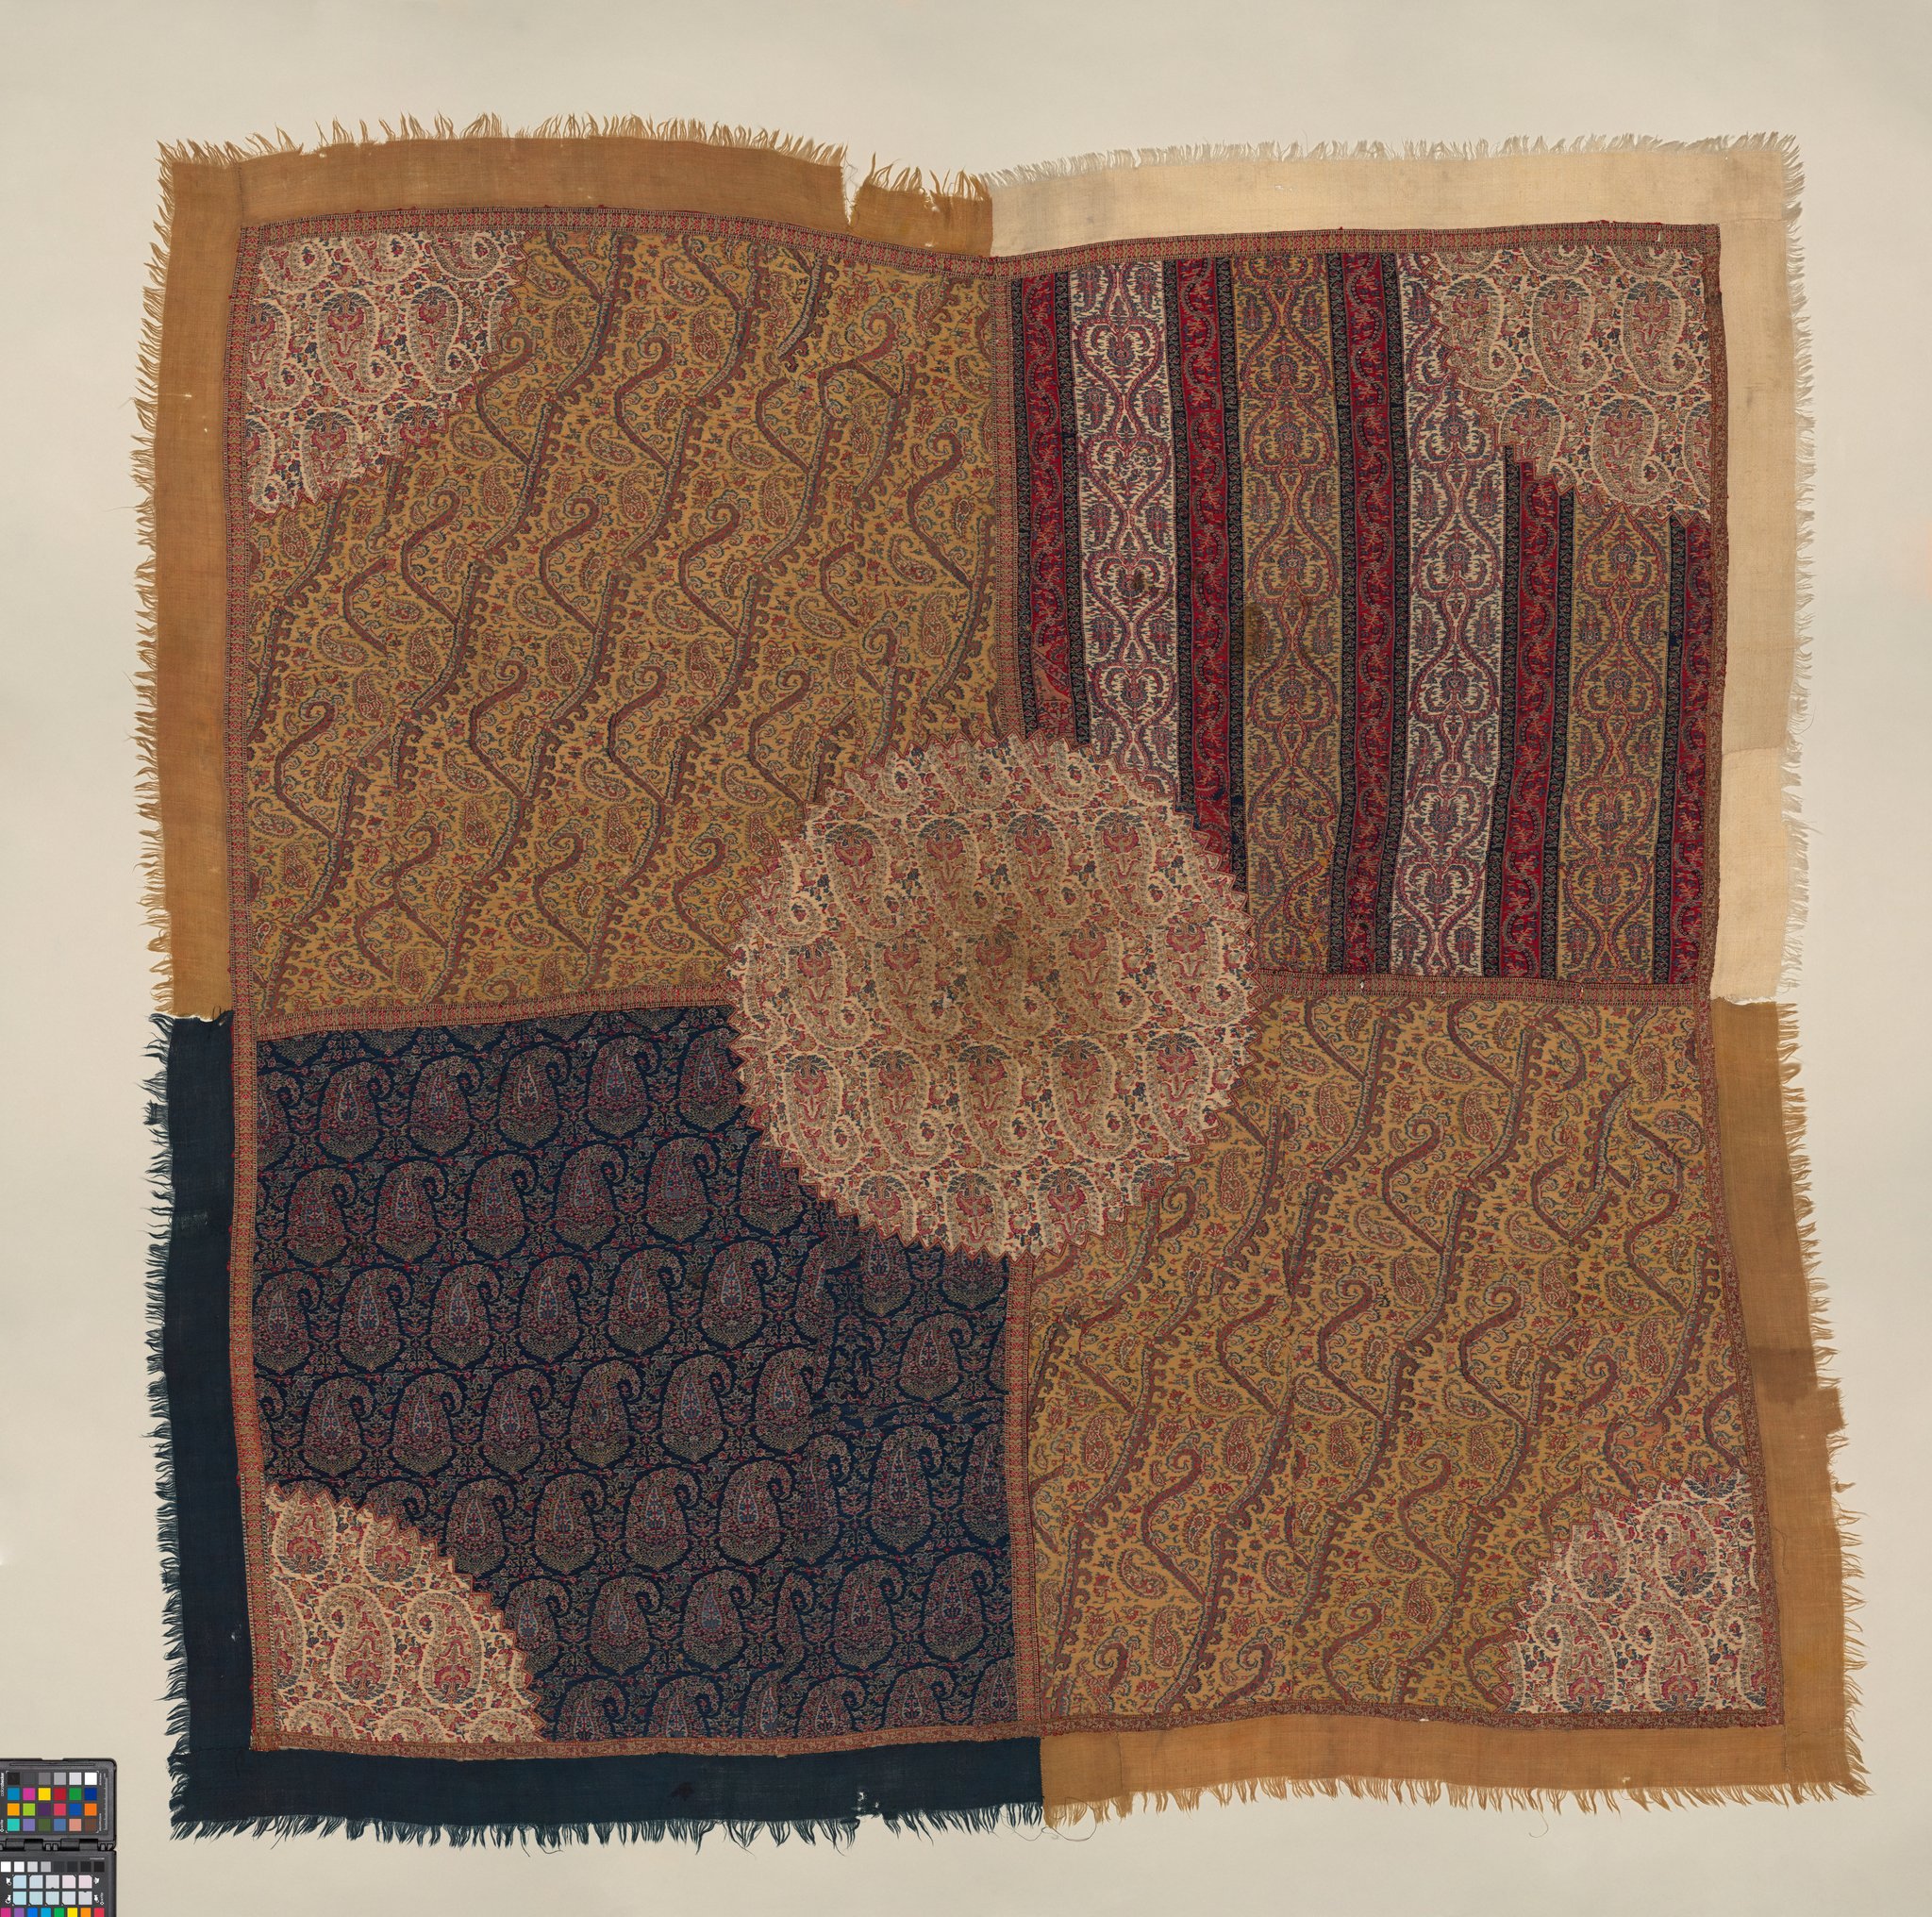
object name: shawl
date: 1801-1850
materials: wool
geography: india